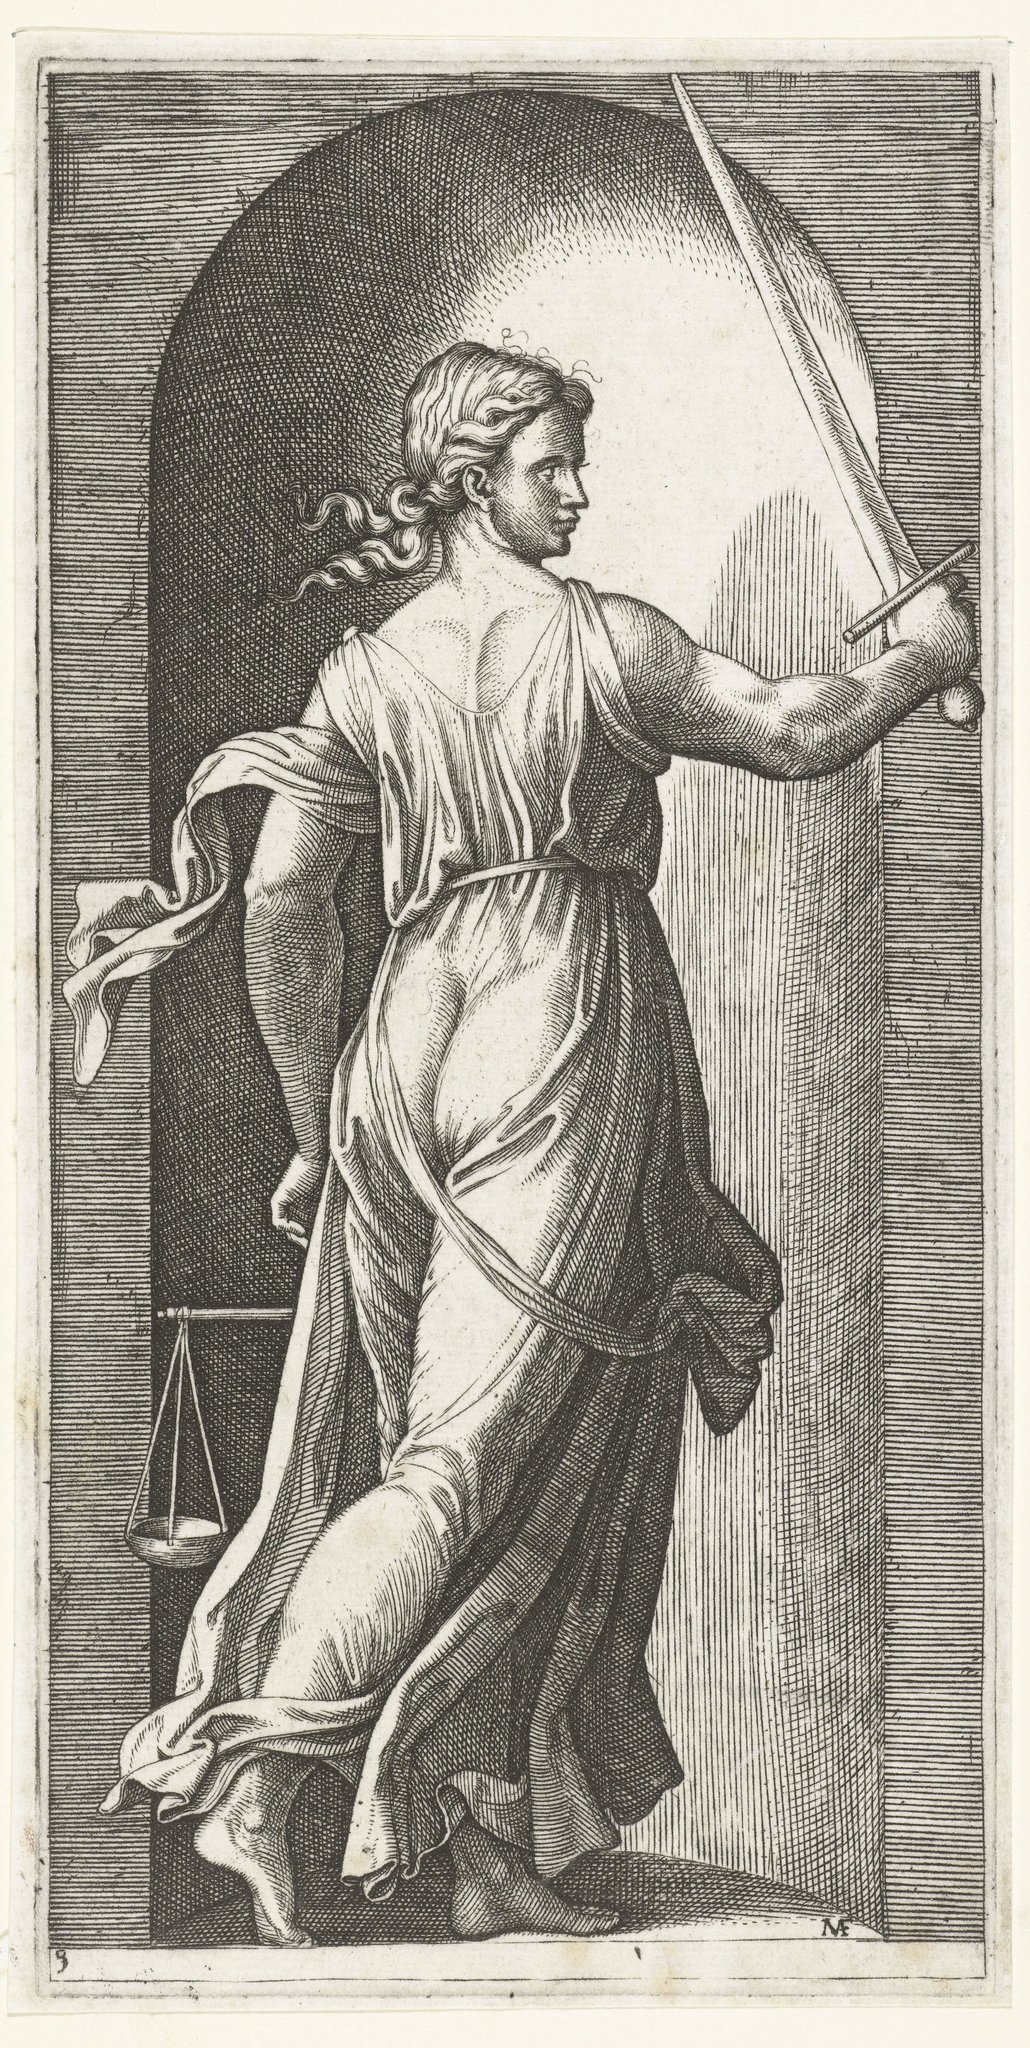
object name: print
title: Vrouw als personificatie van Rechtvaardigheid (Justitia) met weegschaal en zwaard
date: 1510-1527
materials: paper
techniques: engraving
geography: italy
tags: justice, 'justitia'; 'giustitia divina' (ripa) ~ one of the four cardinal virtues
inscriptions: collector's mark: Lugt 240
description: Prent mogelijk naar ontwerp van Raphael. Prent uit een serie van zeven prenten met Deugden.